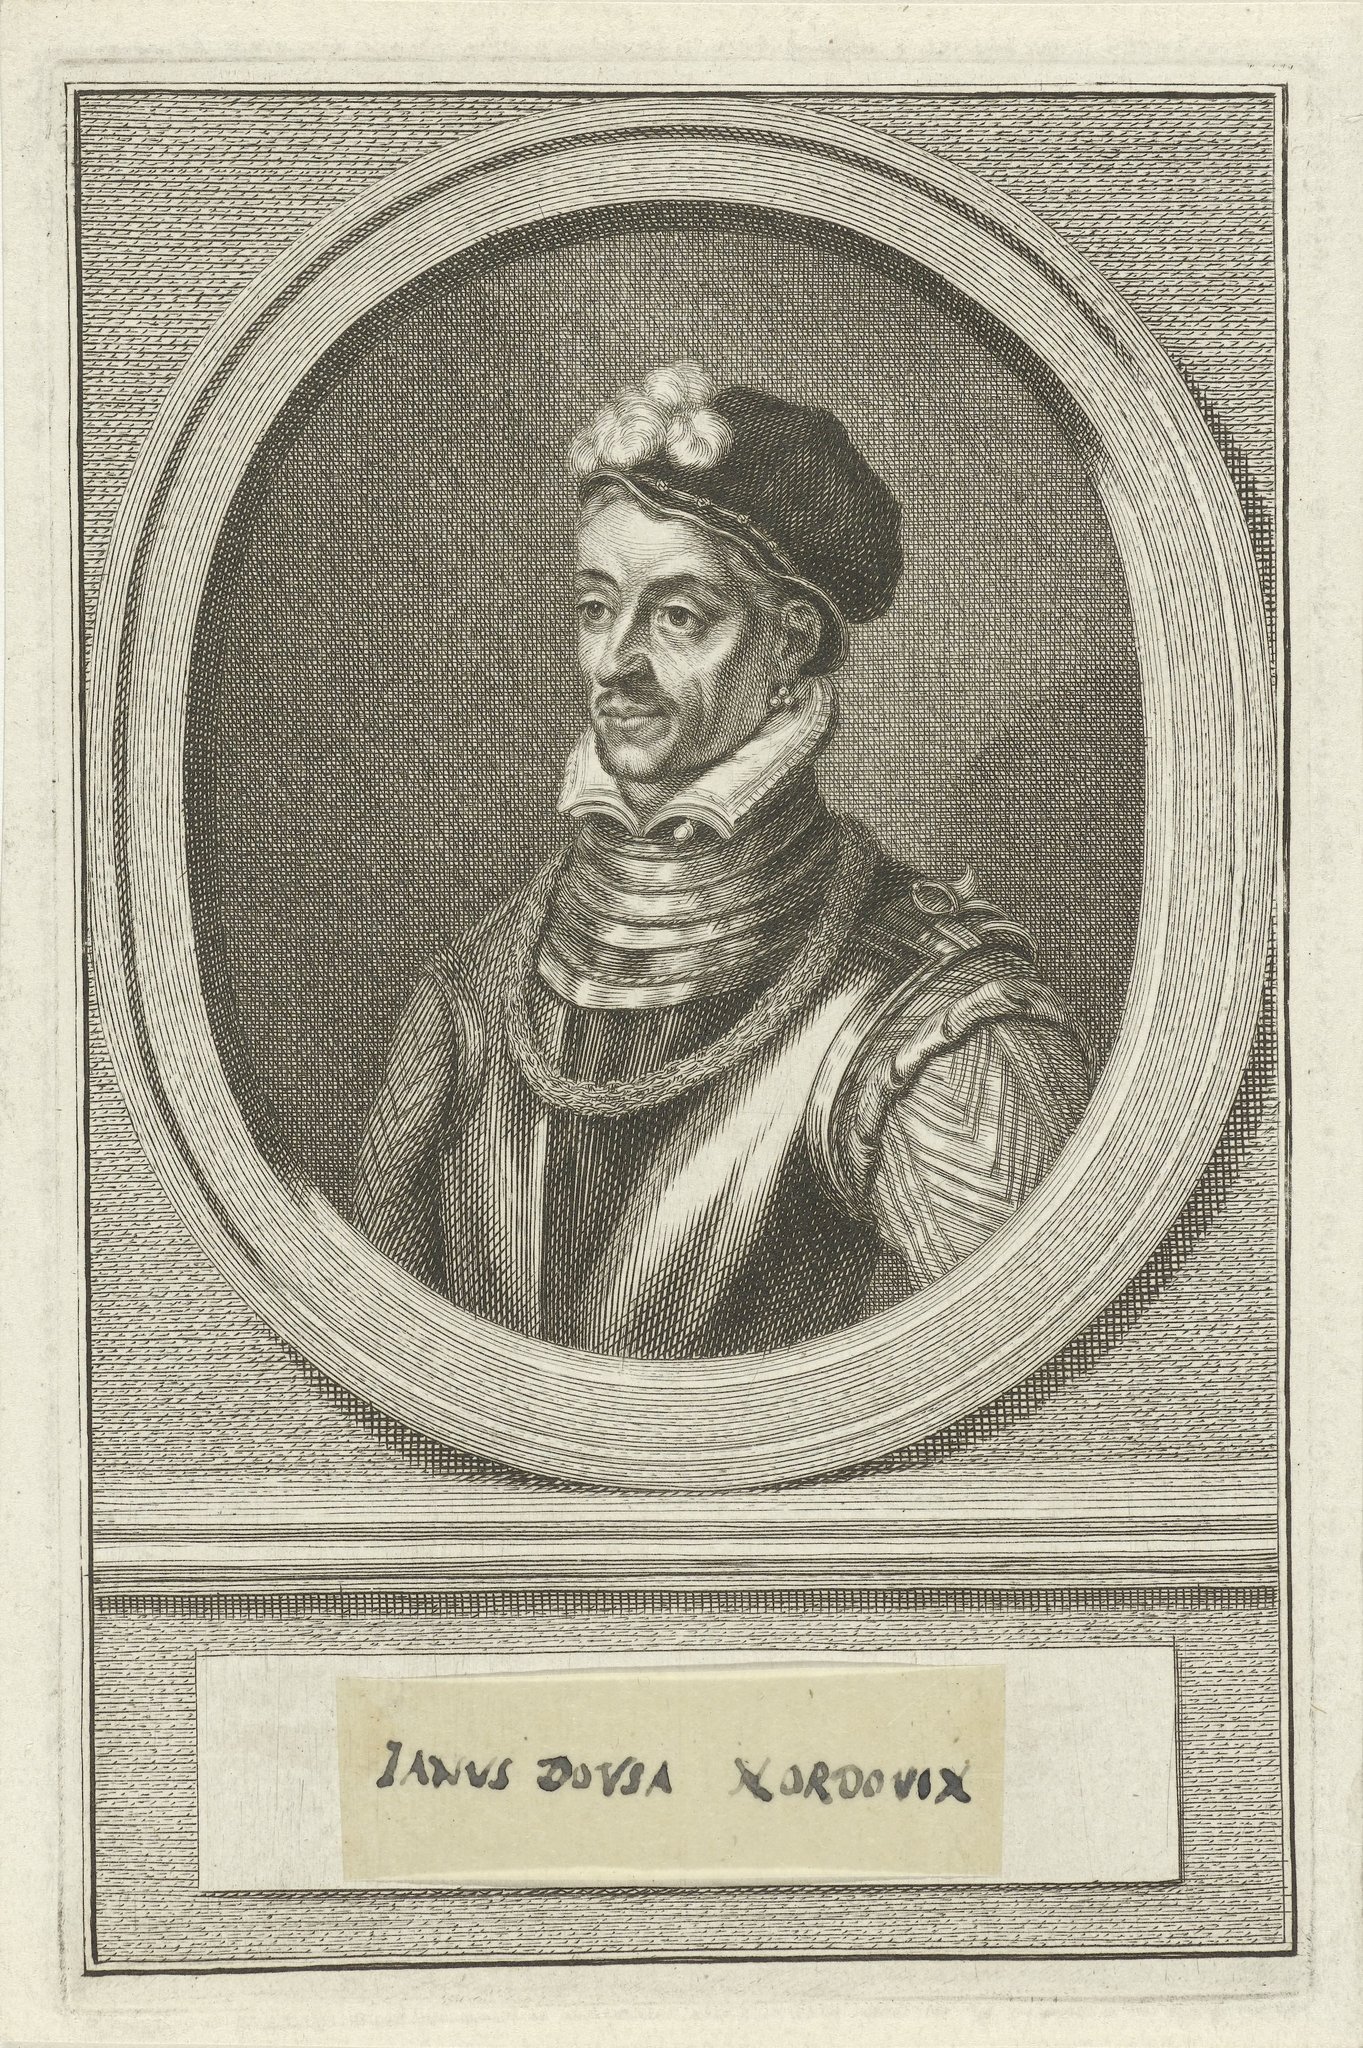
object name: print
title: Ianus Dovsa Nordovix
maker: jacob houbraken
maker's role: draughtsman, print maker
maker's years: 1698-1780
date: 1772-1774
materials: paper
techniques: engraving, pen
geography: amsterdam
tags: filoloog, bestuurder, jan van der does (heer van noordwijk en kattendijke)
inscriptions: inscription: ‘Ianus Dovsa Nordovix’, collector's mark: Lugt 2228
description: Proefdruk van de prent volgens Ver Huell gebruikt in: Lucretia Wilhelmina van Winter geboren van Merken, Het beleg der stad Leyden. Treurspel. Amsterdam: Pieter Meijer, 1774. Variant in spiegelbeeld, van latere datum, van de prent gebruikt in: Jan Wagenaar, Vaderlandsche historie, vervattende de geschiedenissen der nu Vereenigde Nederlanden, inzonderheid die van Holland (...), 21 delen. Amsterdam, Isaak Tirion, 1749-59.